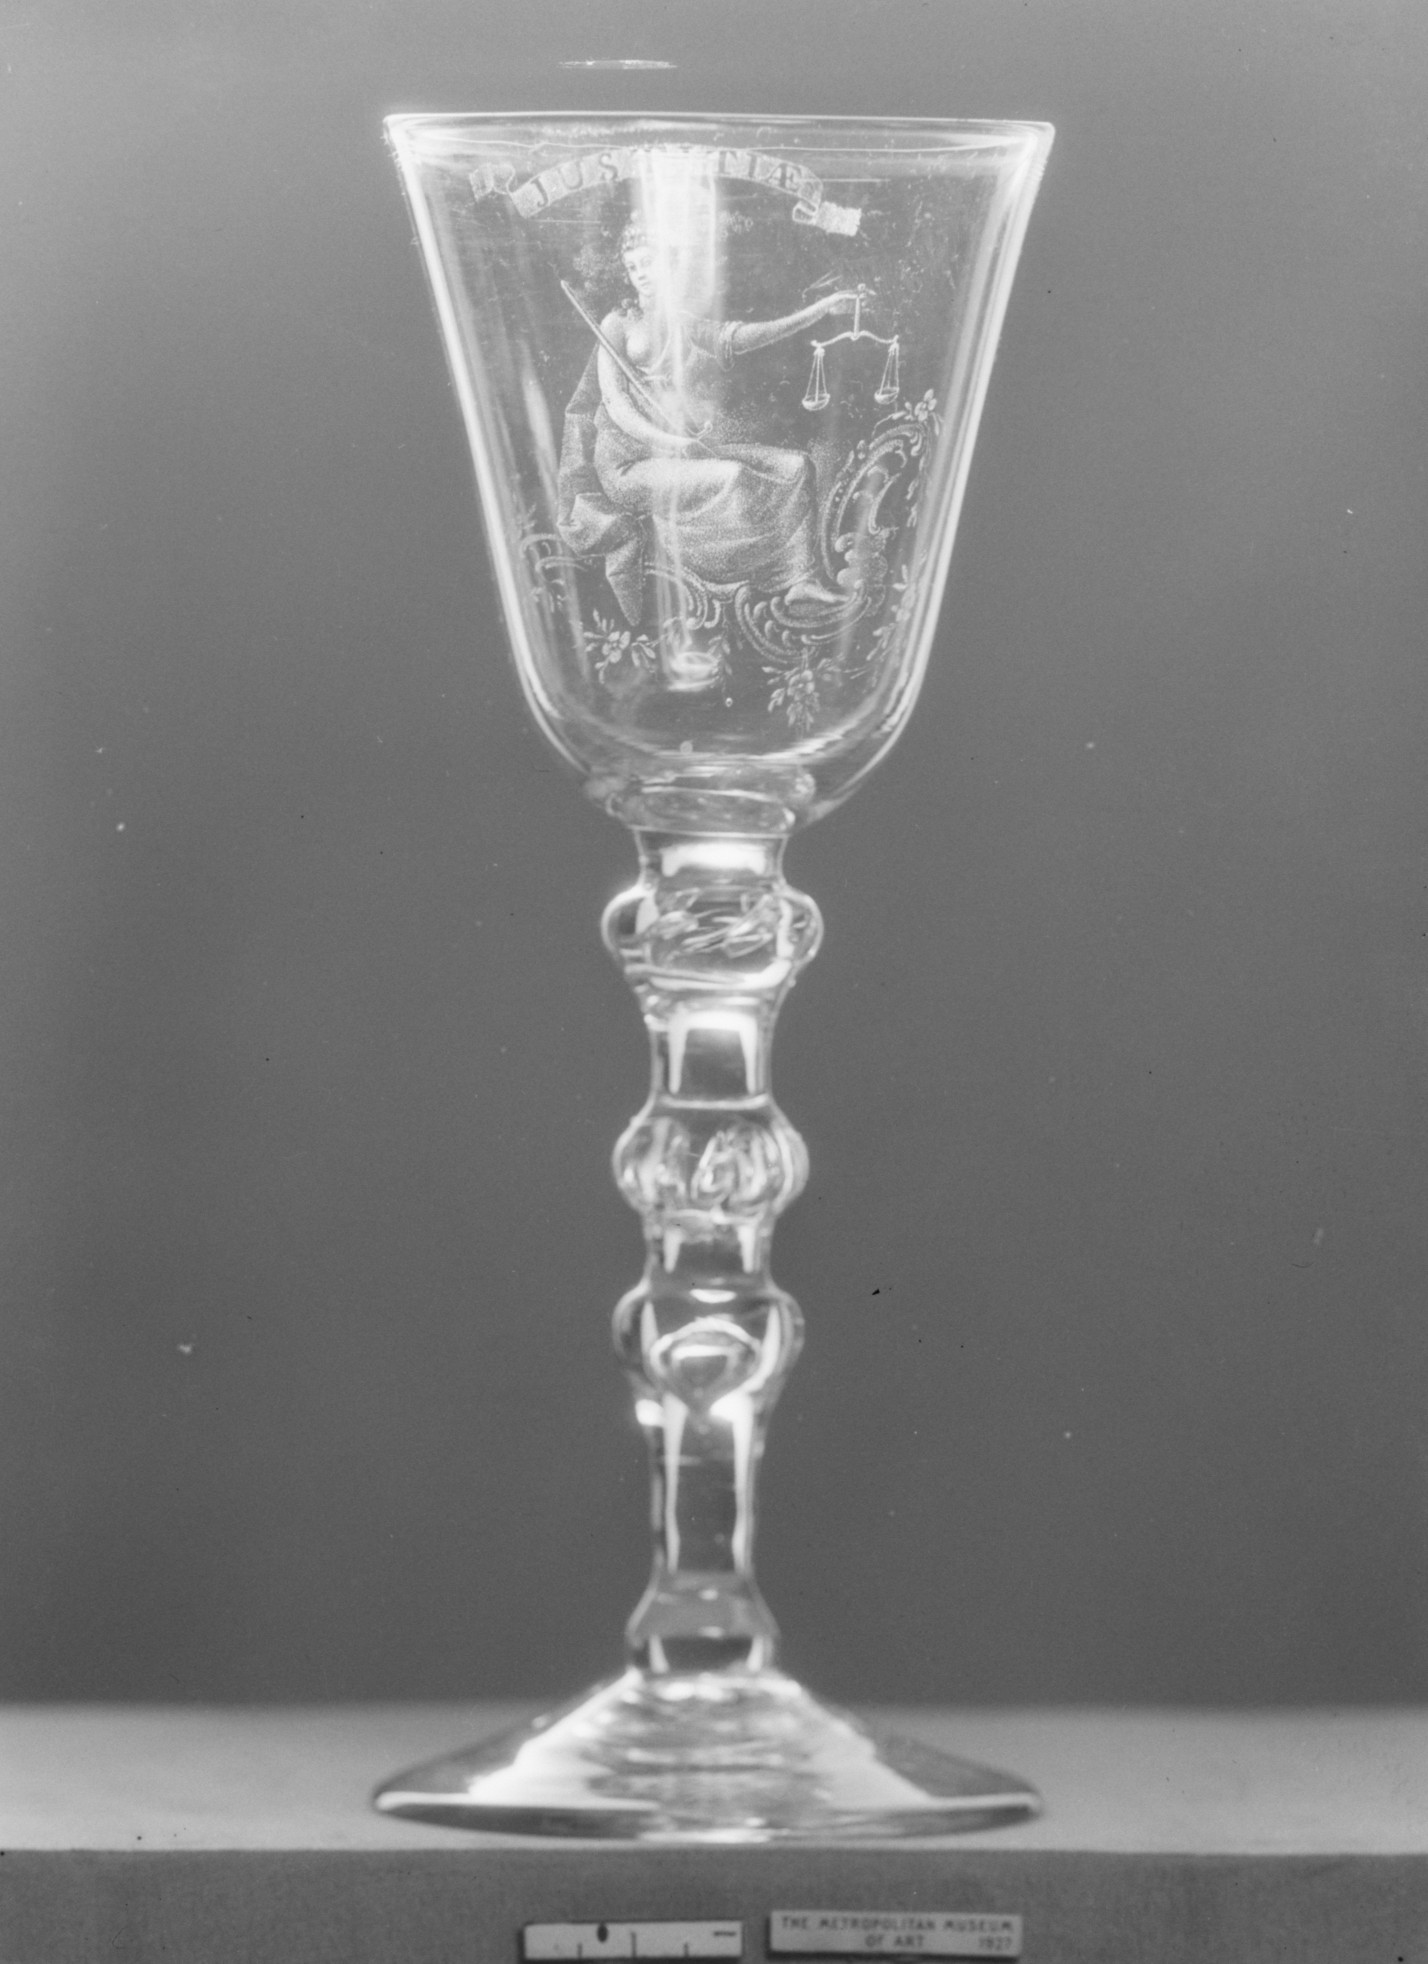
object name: wineglass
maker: william fortuyn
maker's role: maker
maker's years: 1727-1800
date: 1701-1800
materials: glass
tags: women,flowers,coat of arms